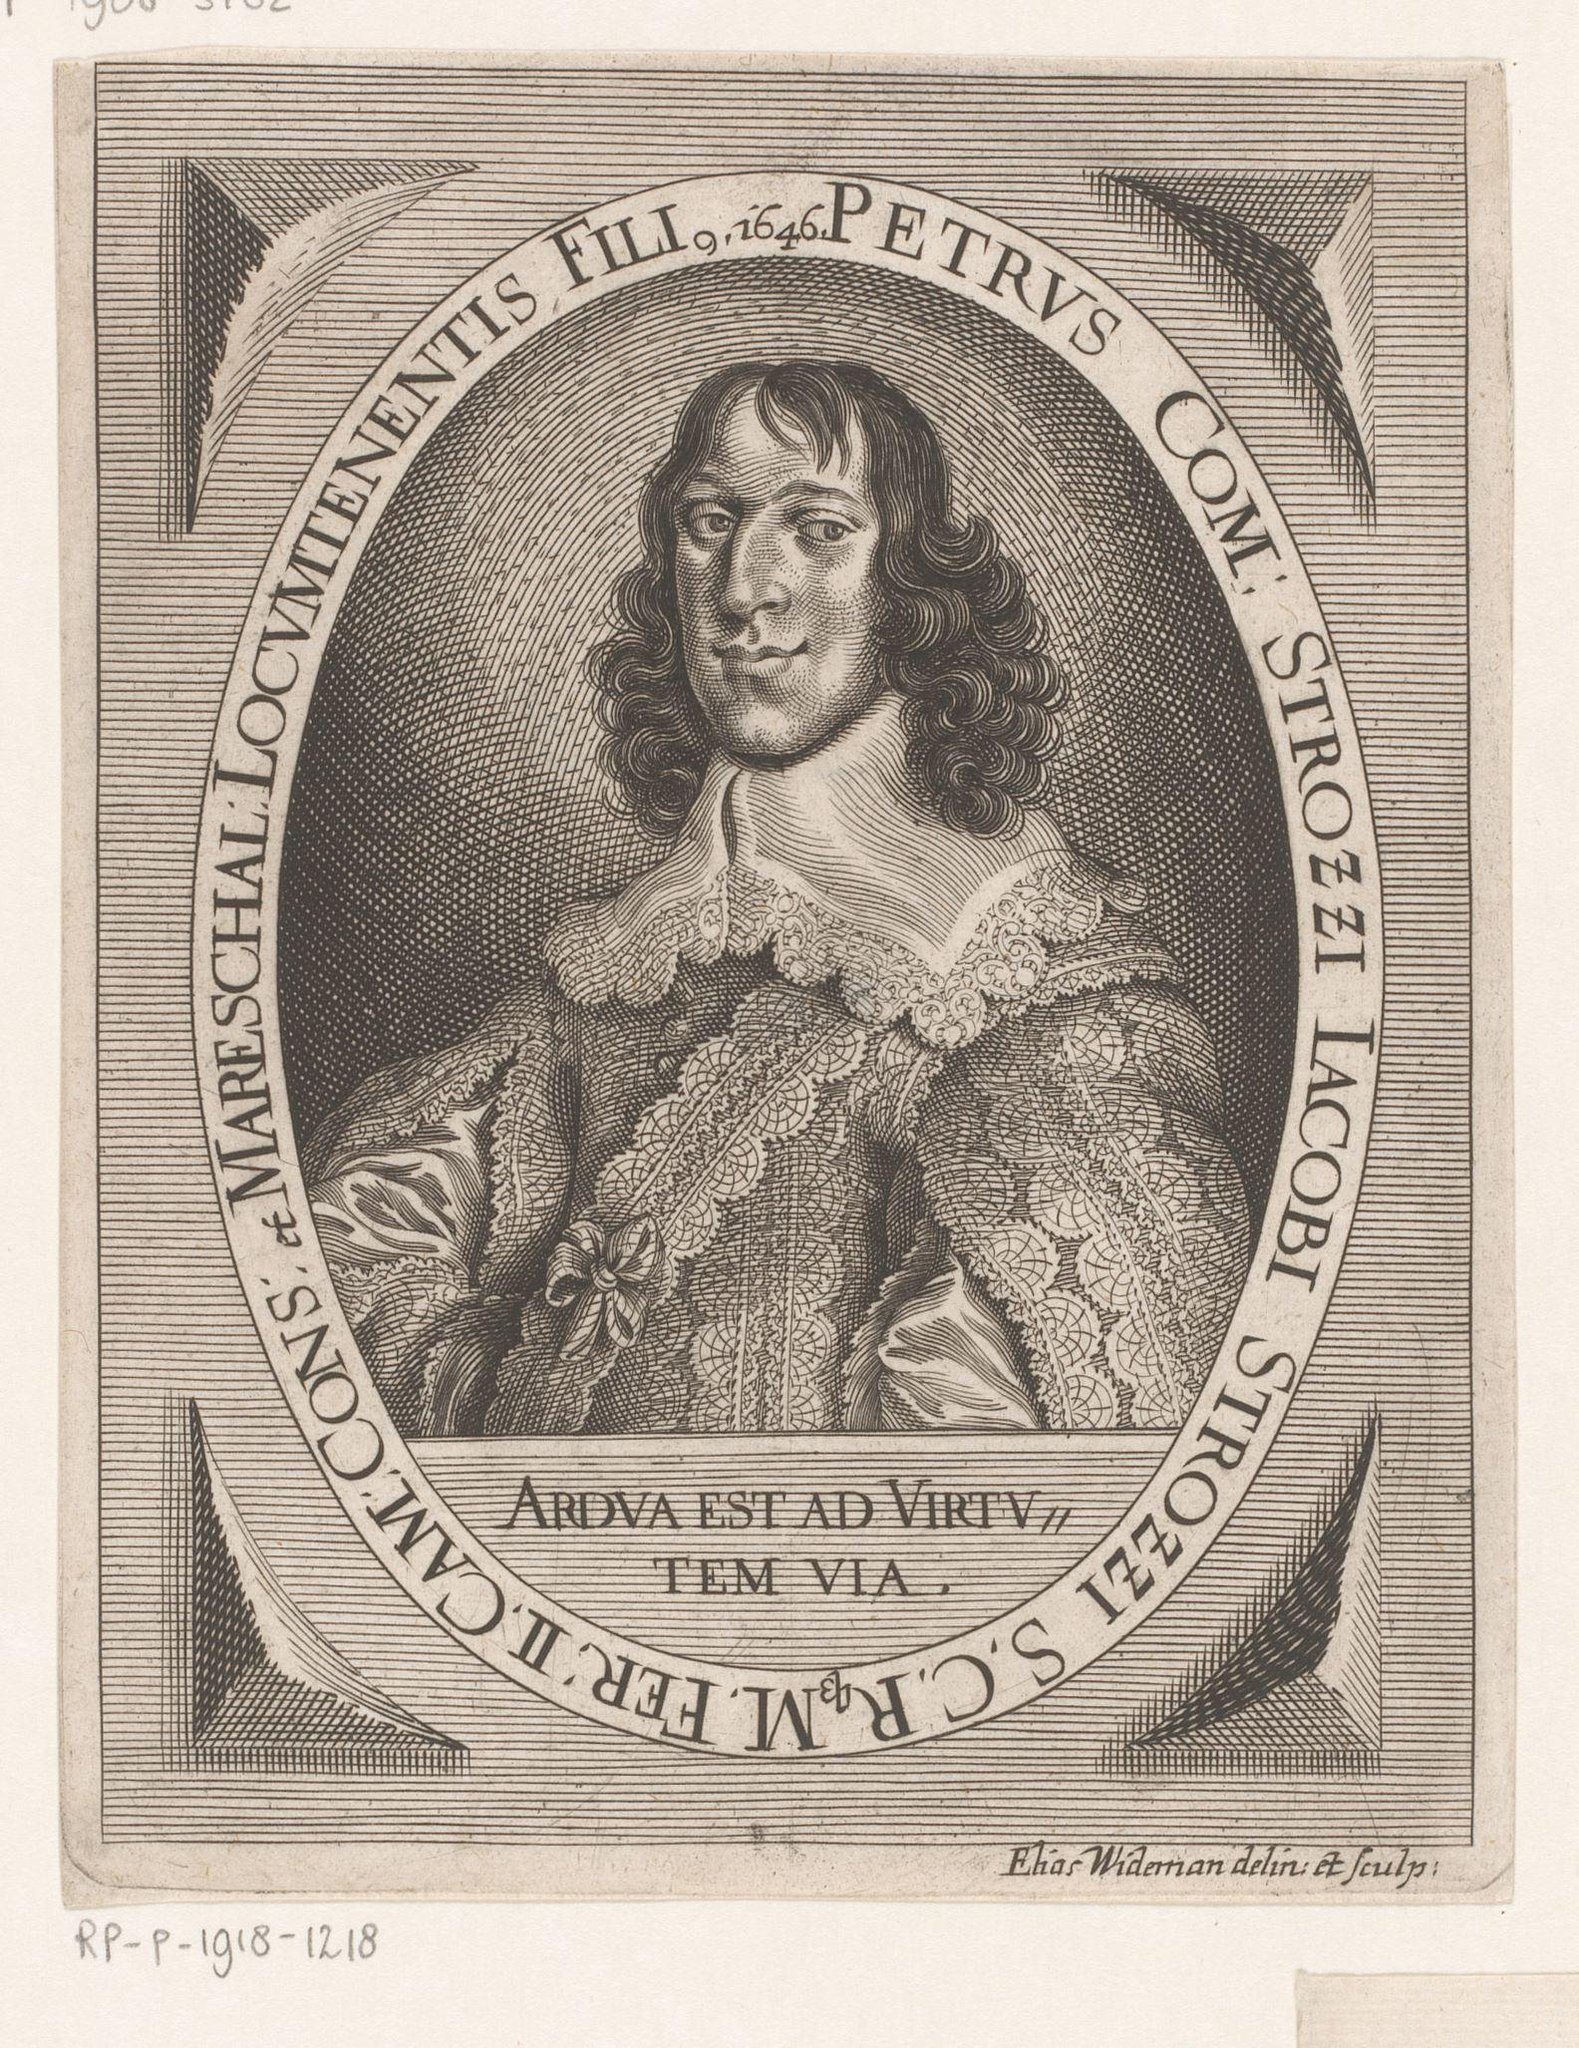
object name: print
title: Portret van Peter Strozzi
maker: elias widemann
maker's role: print maker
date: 1646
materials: paper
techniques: engraving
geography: vienna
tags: historical persons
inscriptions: collector's mark: Lugt 2233